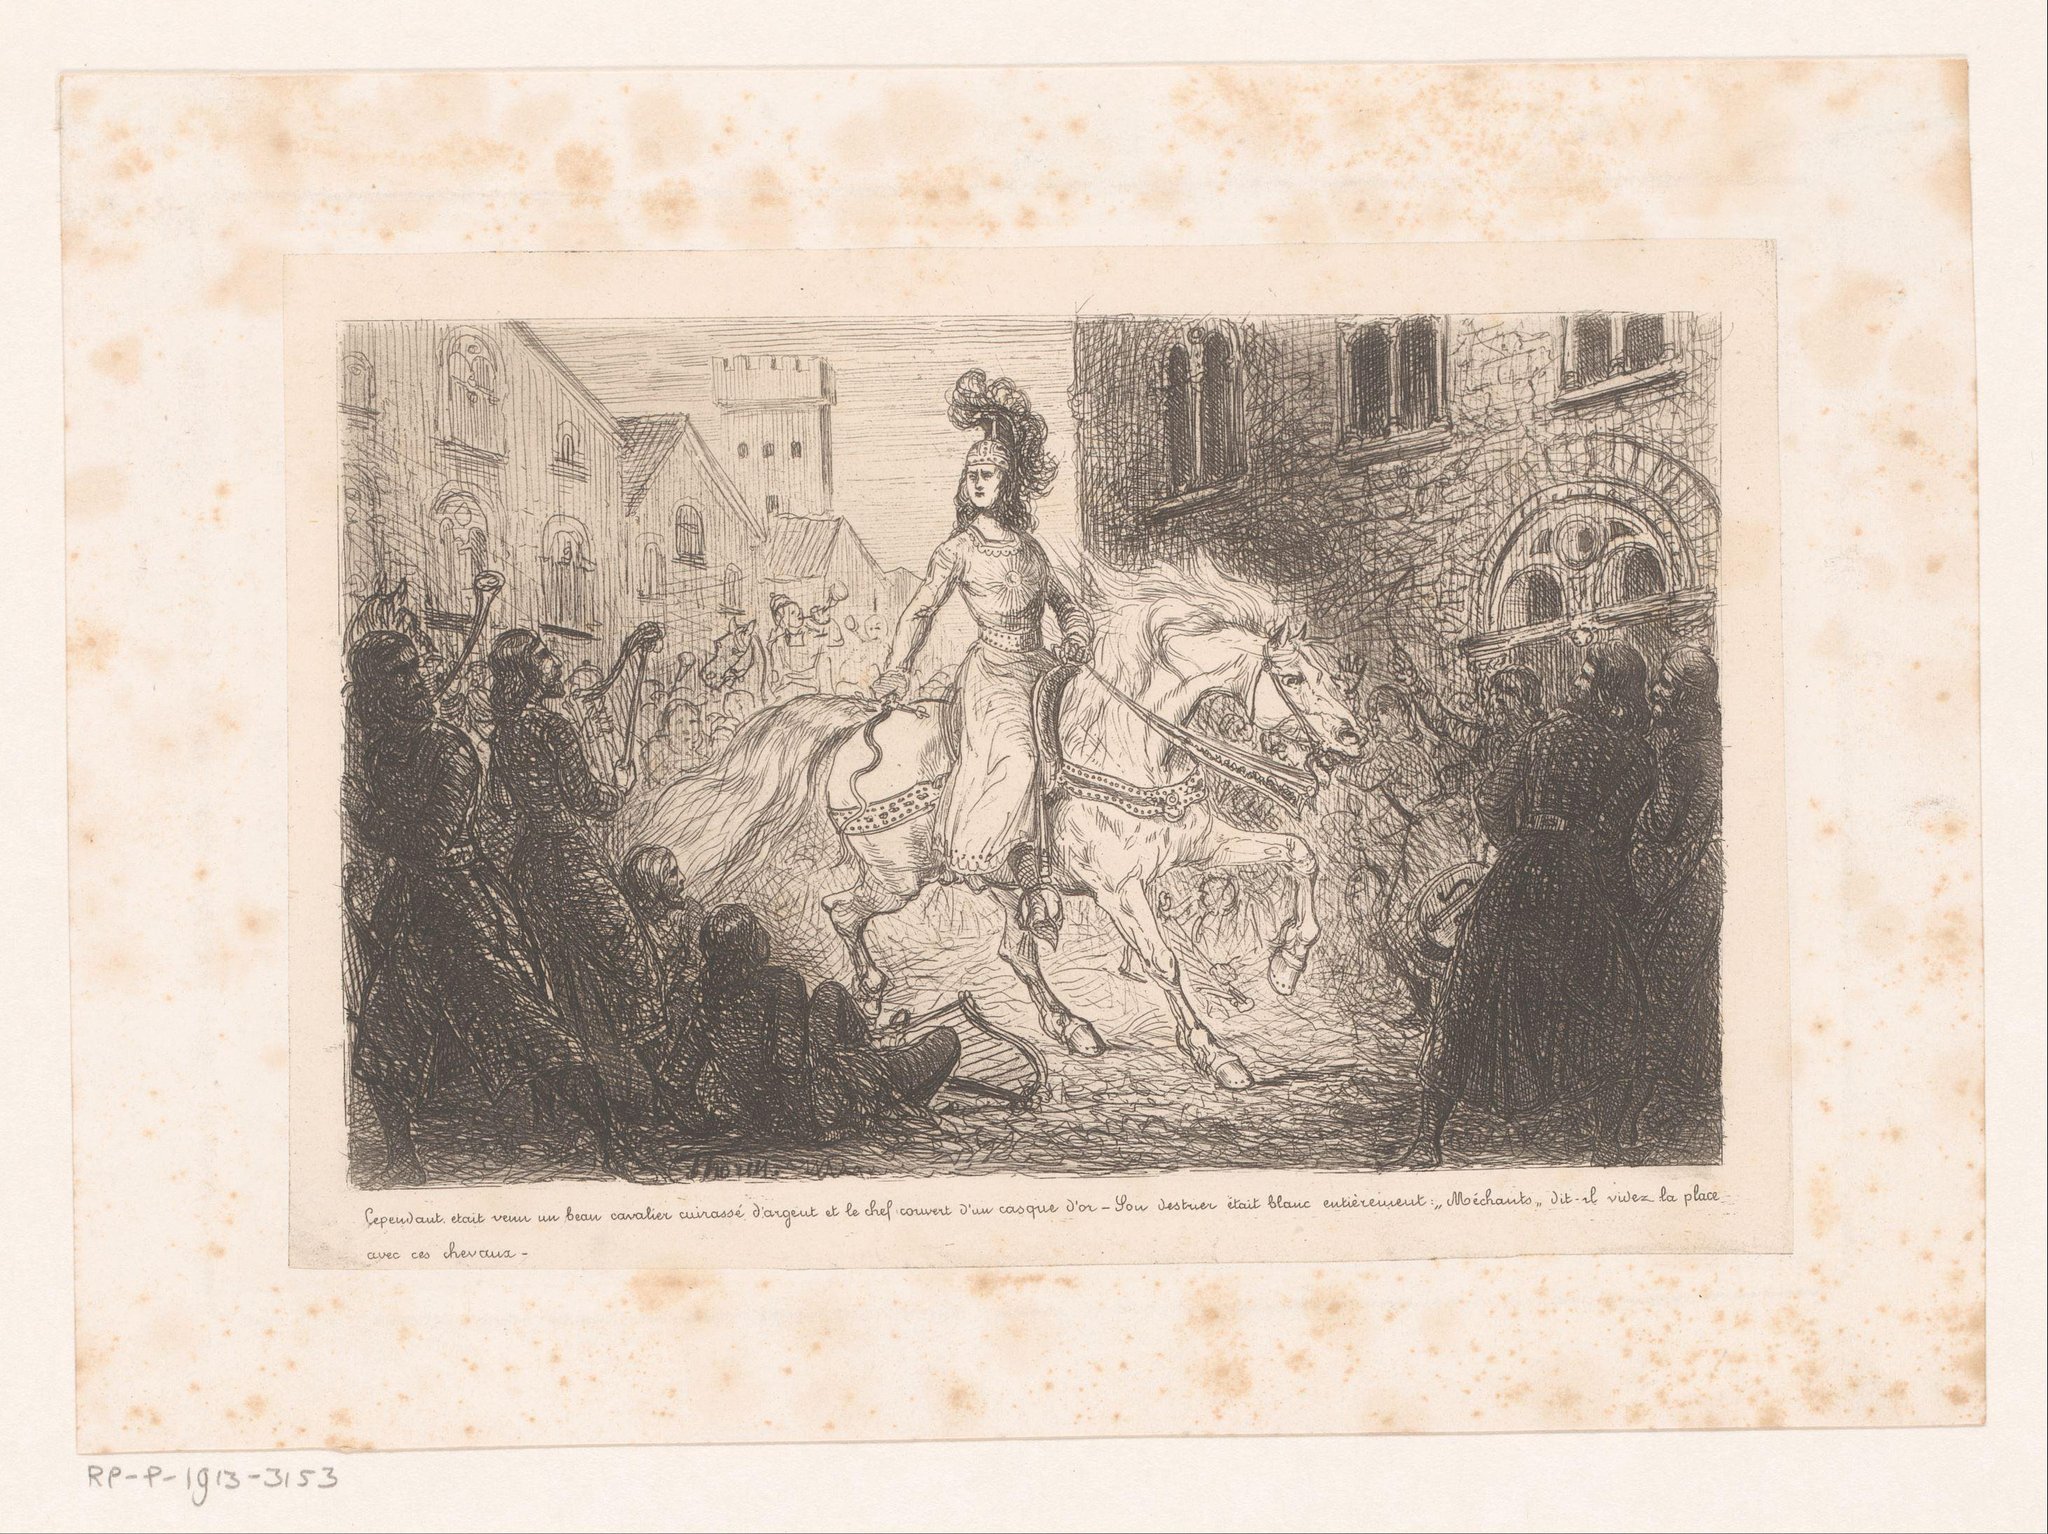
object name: print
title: Optocht in een stad met een ridder te paard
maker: otto von thoren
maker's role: painter, print maker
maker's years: 1828-1889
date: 1838-1889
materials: paper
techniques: etching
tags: riding a horse, ass, or mule; rider, horseman, armour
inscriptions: collector's mark: Lugt 1485, collector's mark: Lugt 2228